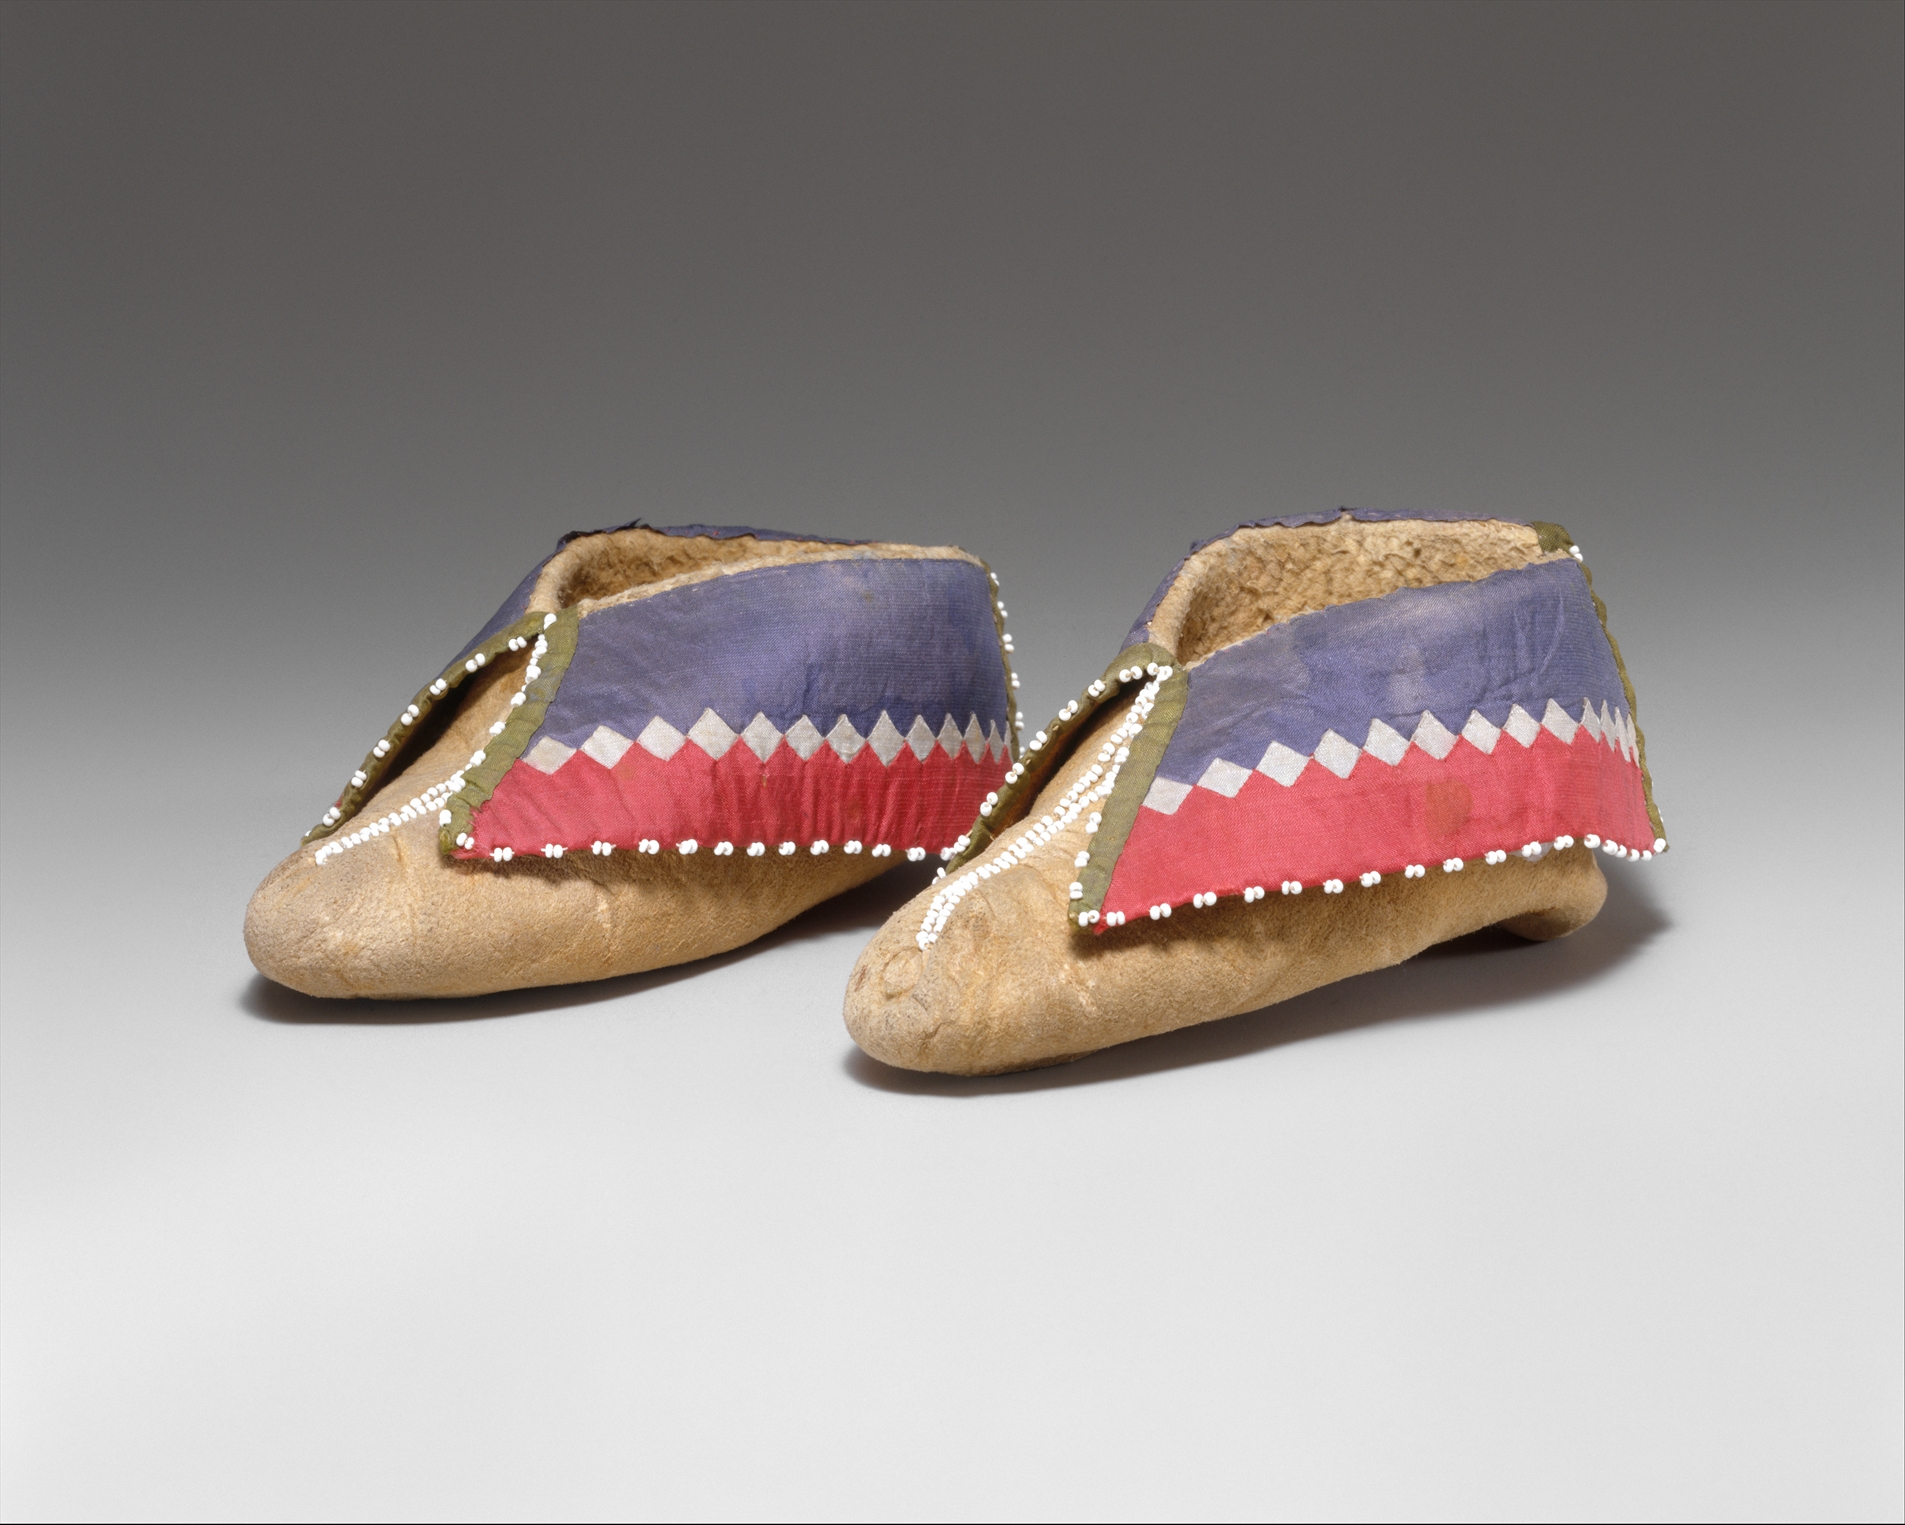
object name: moccasin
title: Pair of Moccasins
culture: shawnee or wyandot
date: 1810-1815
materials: glass, silk, skin, thread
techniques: tanning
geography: united states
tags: shoes